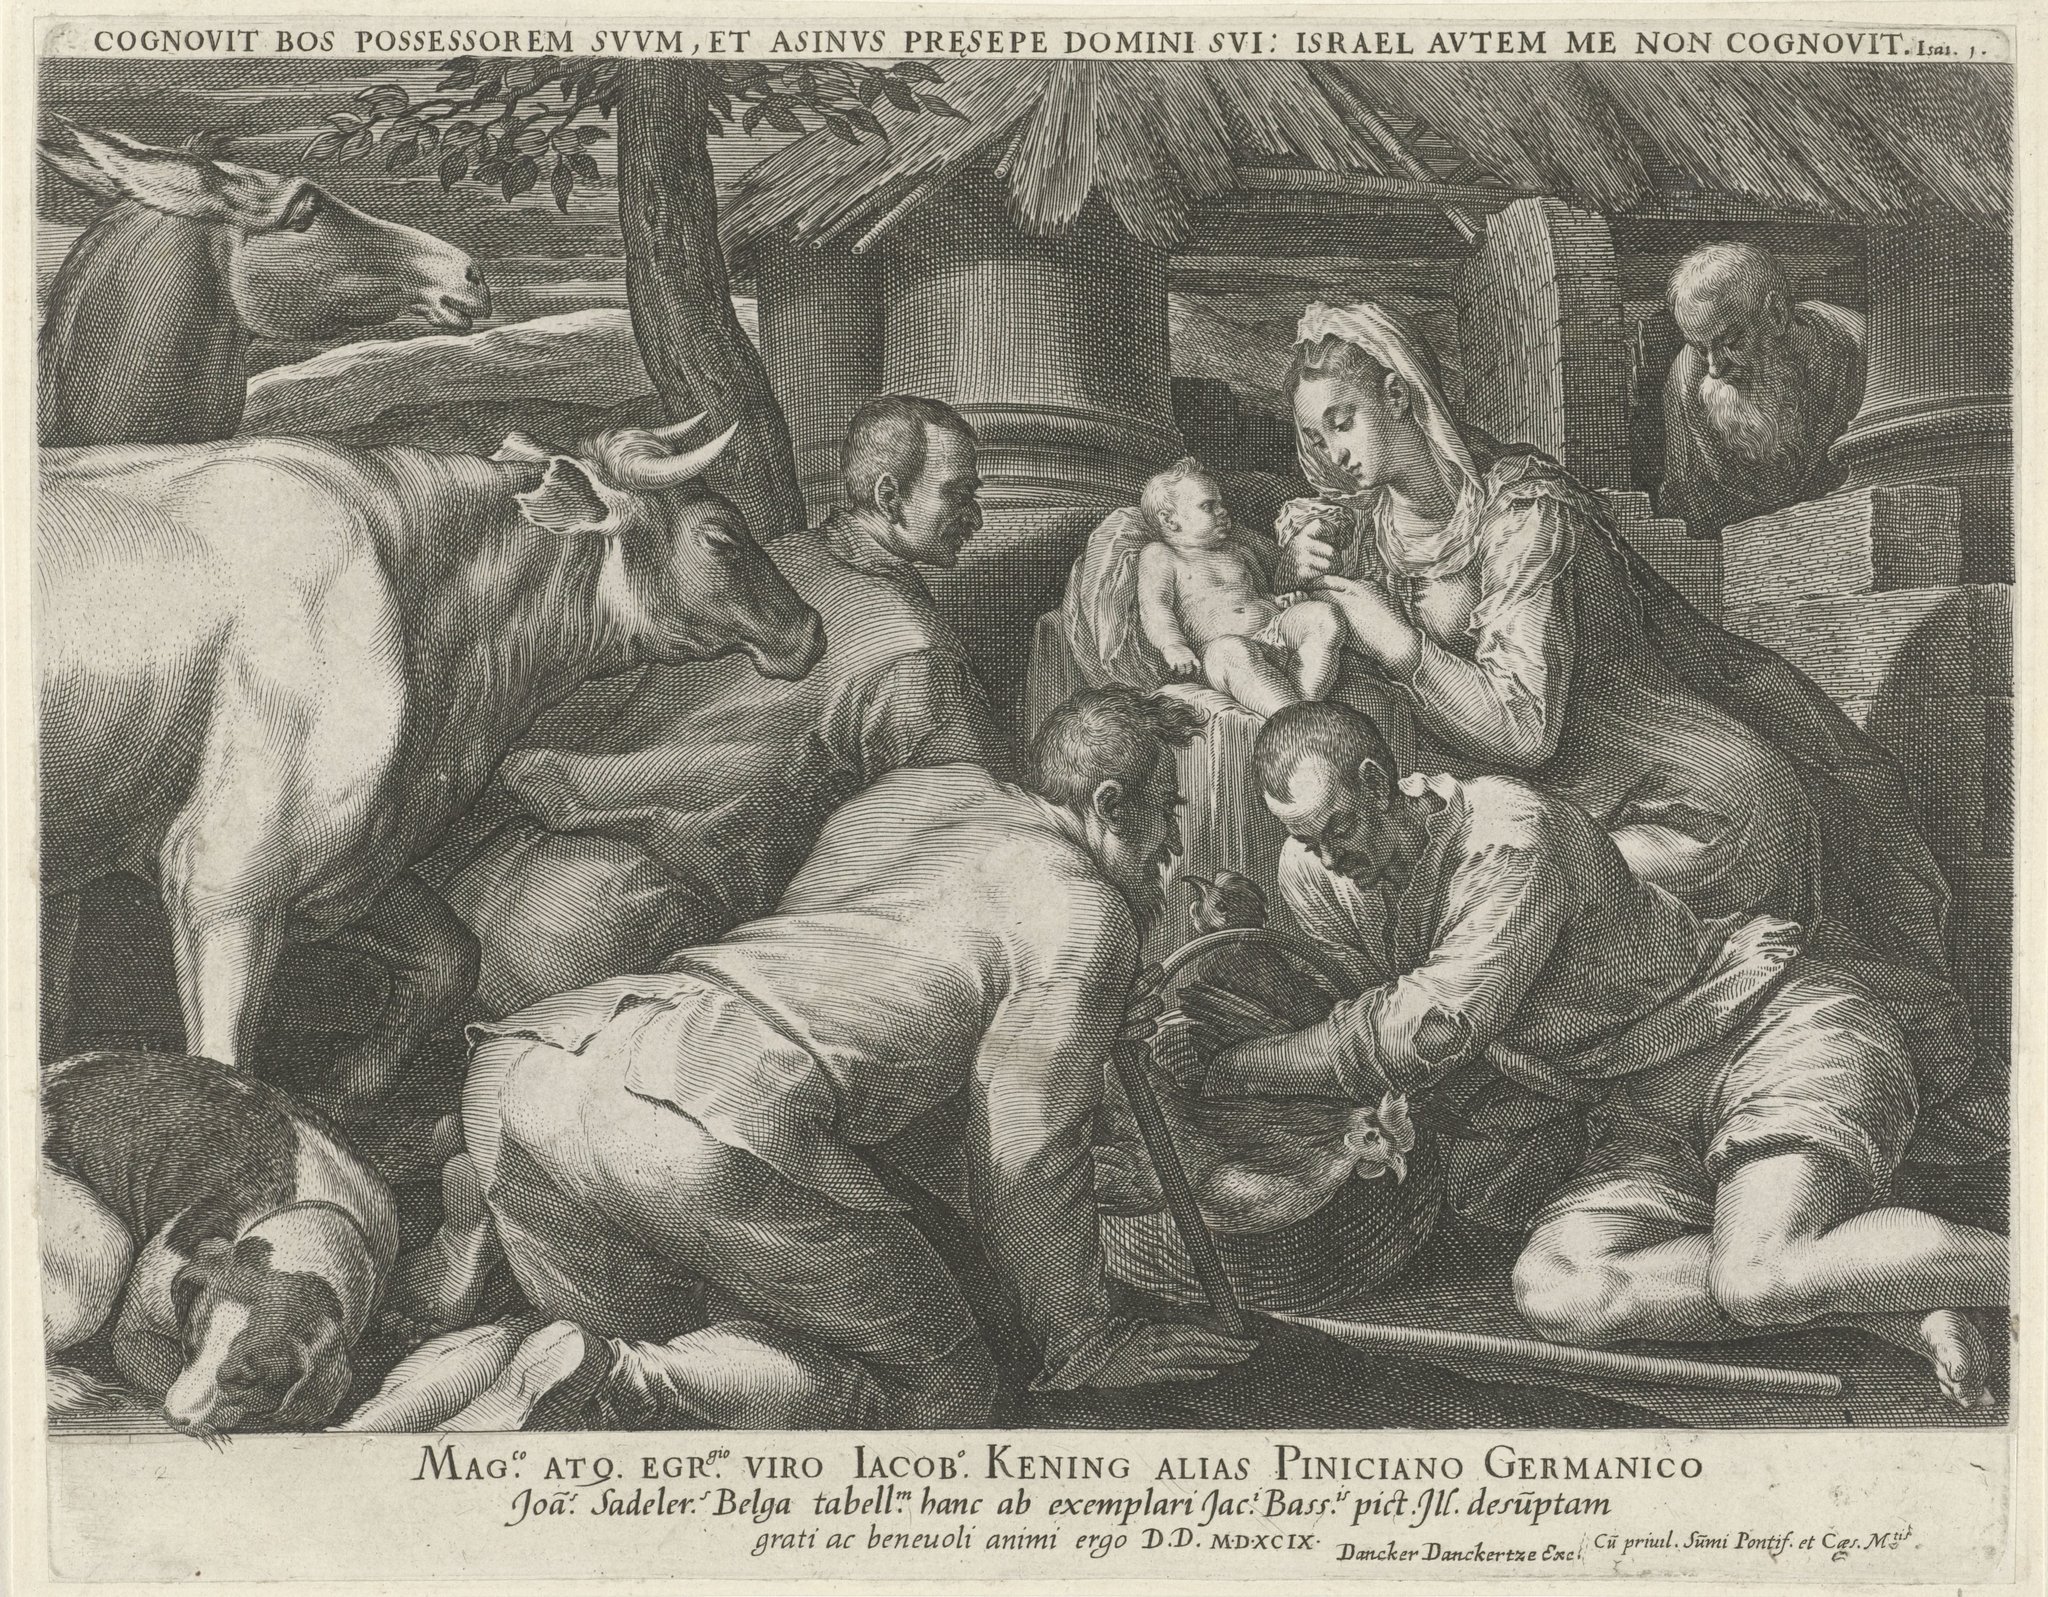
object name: print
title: Aanbidding der herders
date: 1599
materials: paper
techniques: engraving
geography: italy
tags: adoration of the christ-child by the shepherds; mary and joseph present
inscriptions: collector's mark: Lugt 2228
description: Drie herders zitten geknield voor de kribbe met het Christuskind. Een van hen heeft twee kippen in een mand. Links de os en de ezel. Rechts Maria en Jozef.